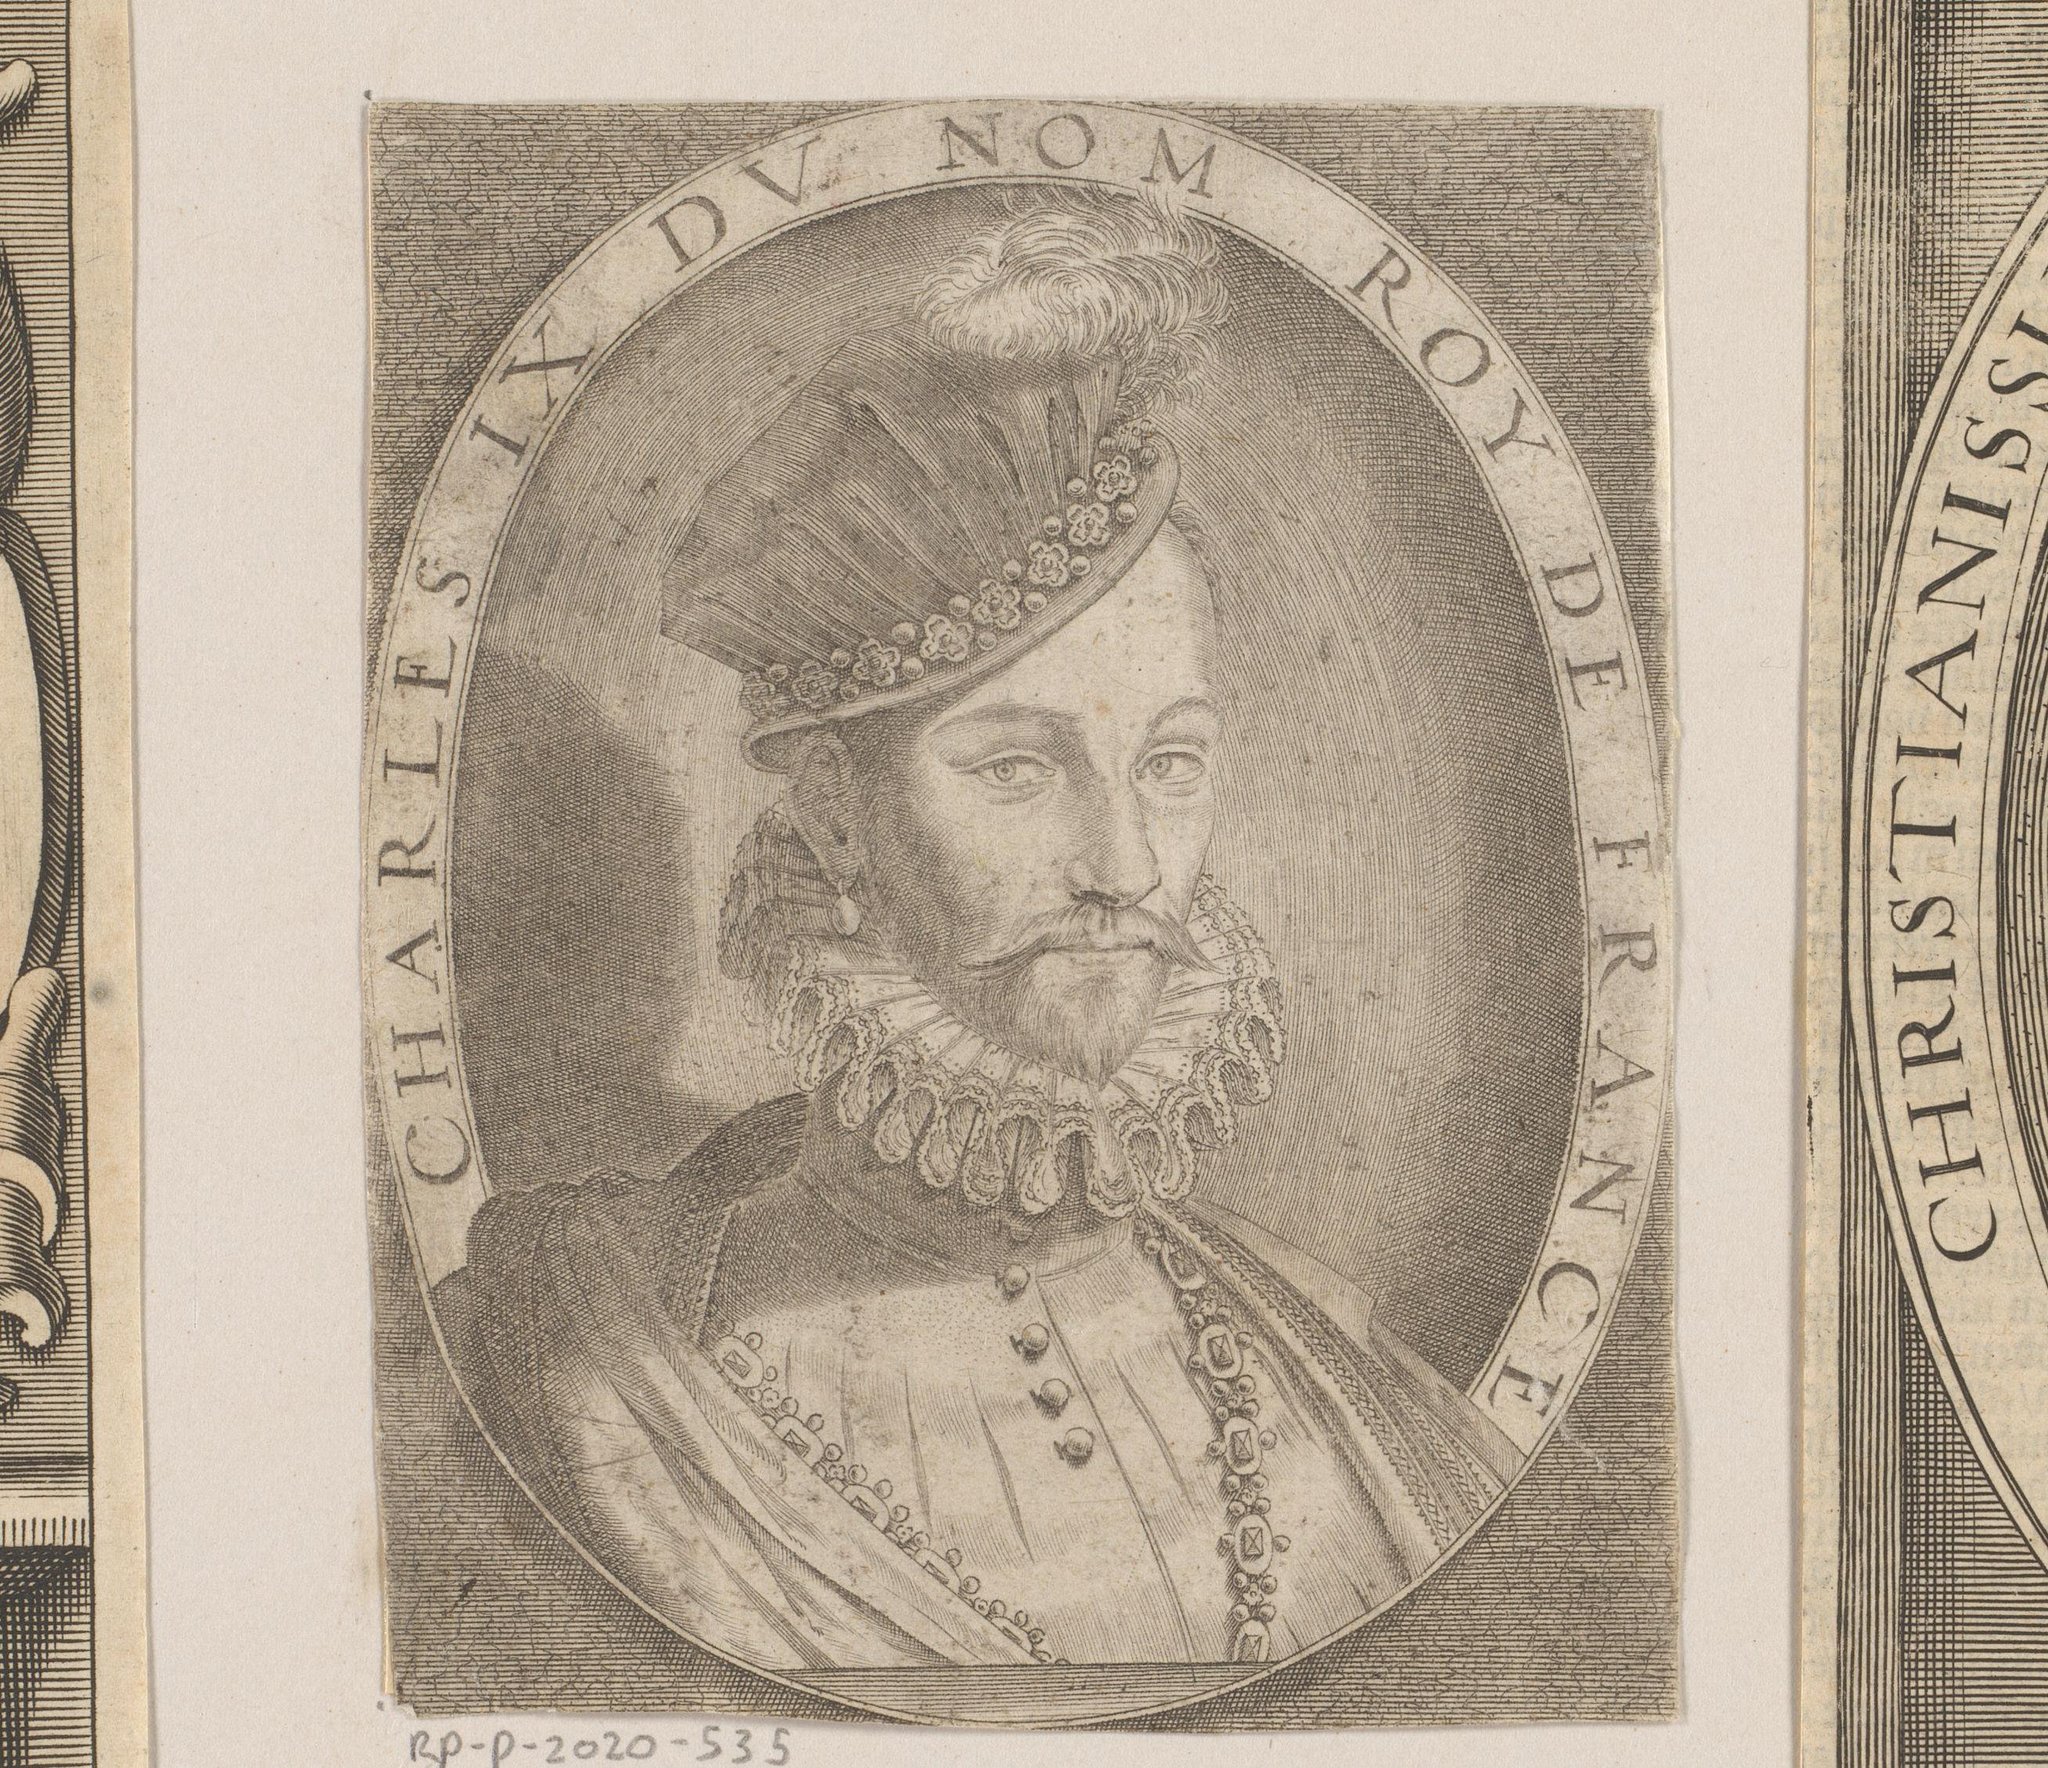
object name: print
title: Portret van Karel IX, koning van Frankrijk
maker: thomas de leu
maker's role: print maker, publisher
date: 1576-1614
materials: paper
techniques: engraving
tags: karel ix (koning van frankrijk), historical persons, king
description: Het vierregelige vers en de naam van de prentmaker is van het blad afgesneden.